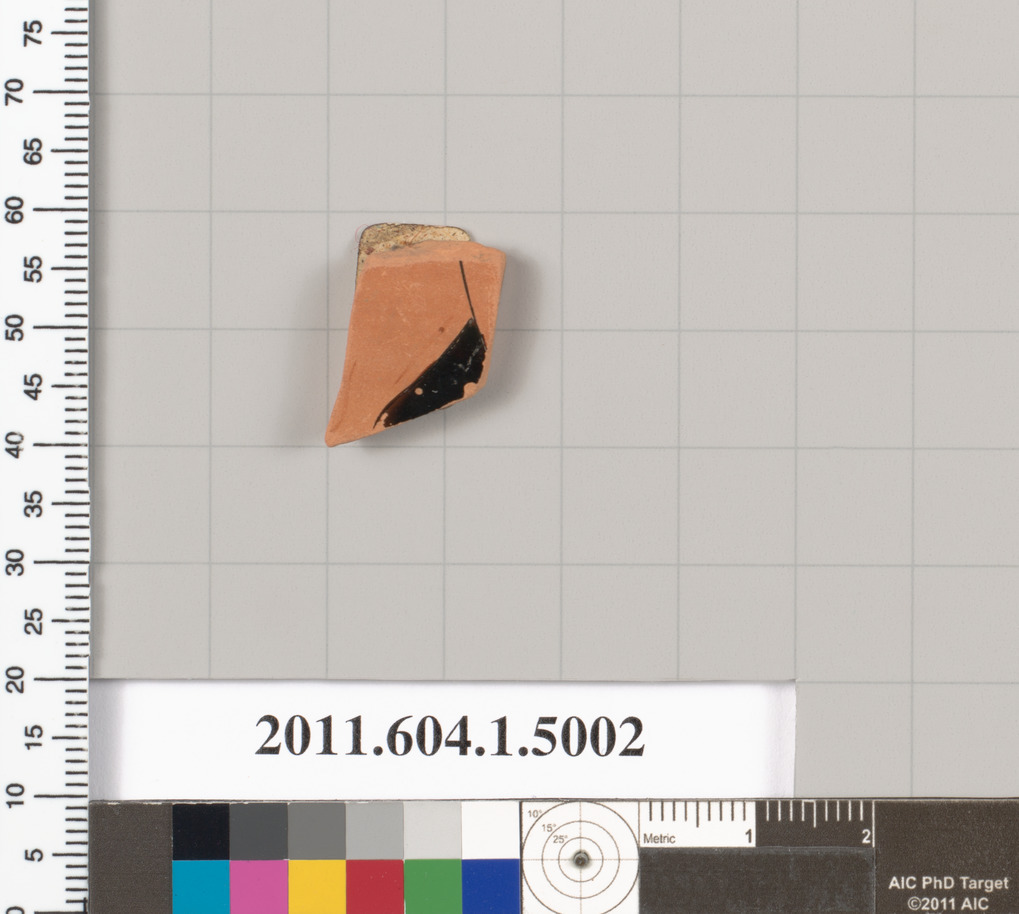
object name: kylix fragment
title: Terracotta fragment of a kylix (drinking cup)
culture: greek, attic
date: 500-480 BCE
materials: terracotta